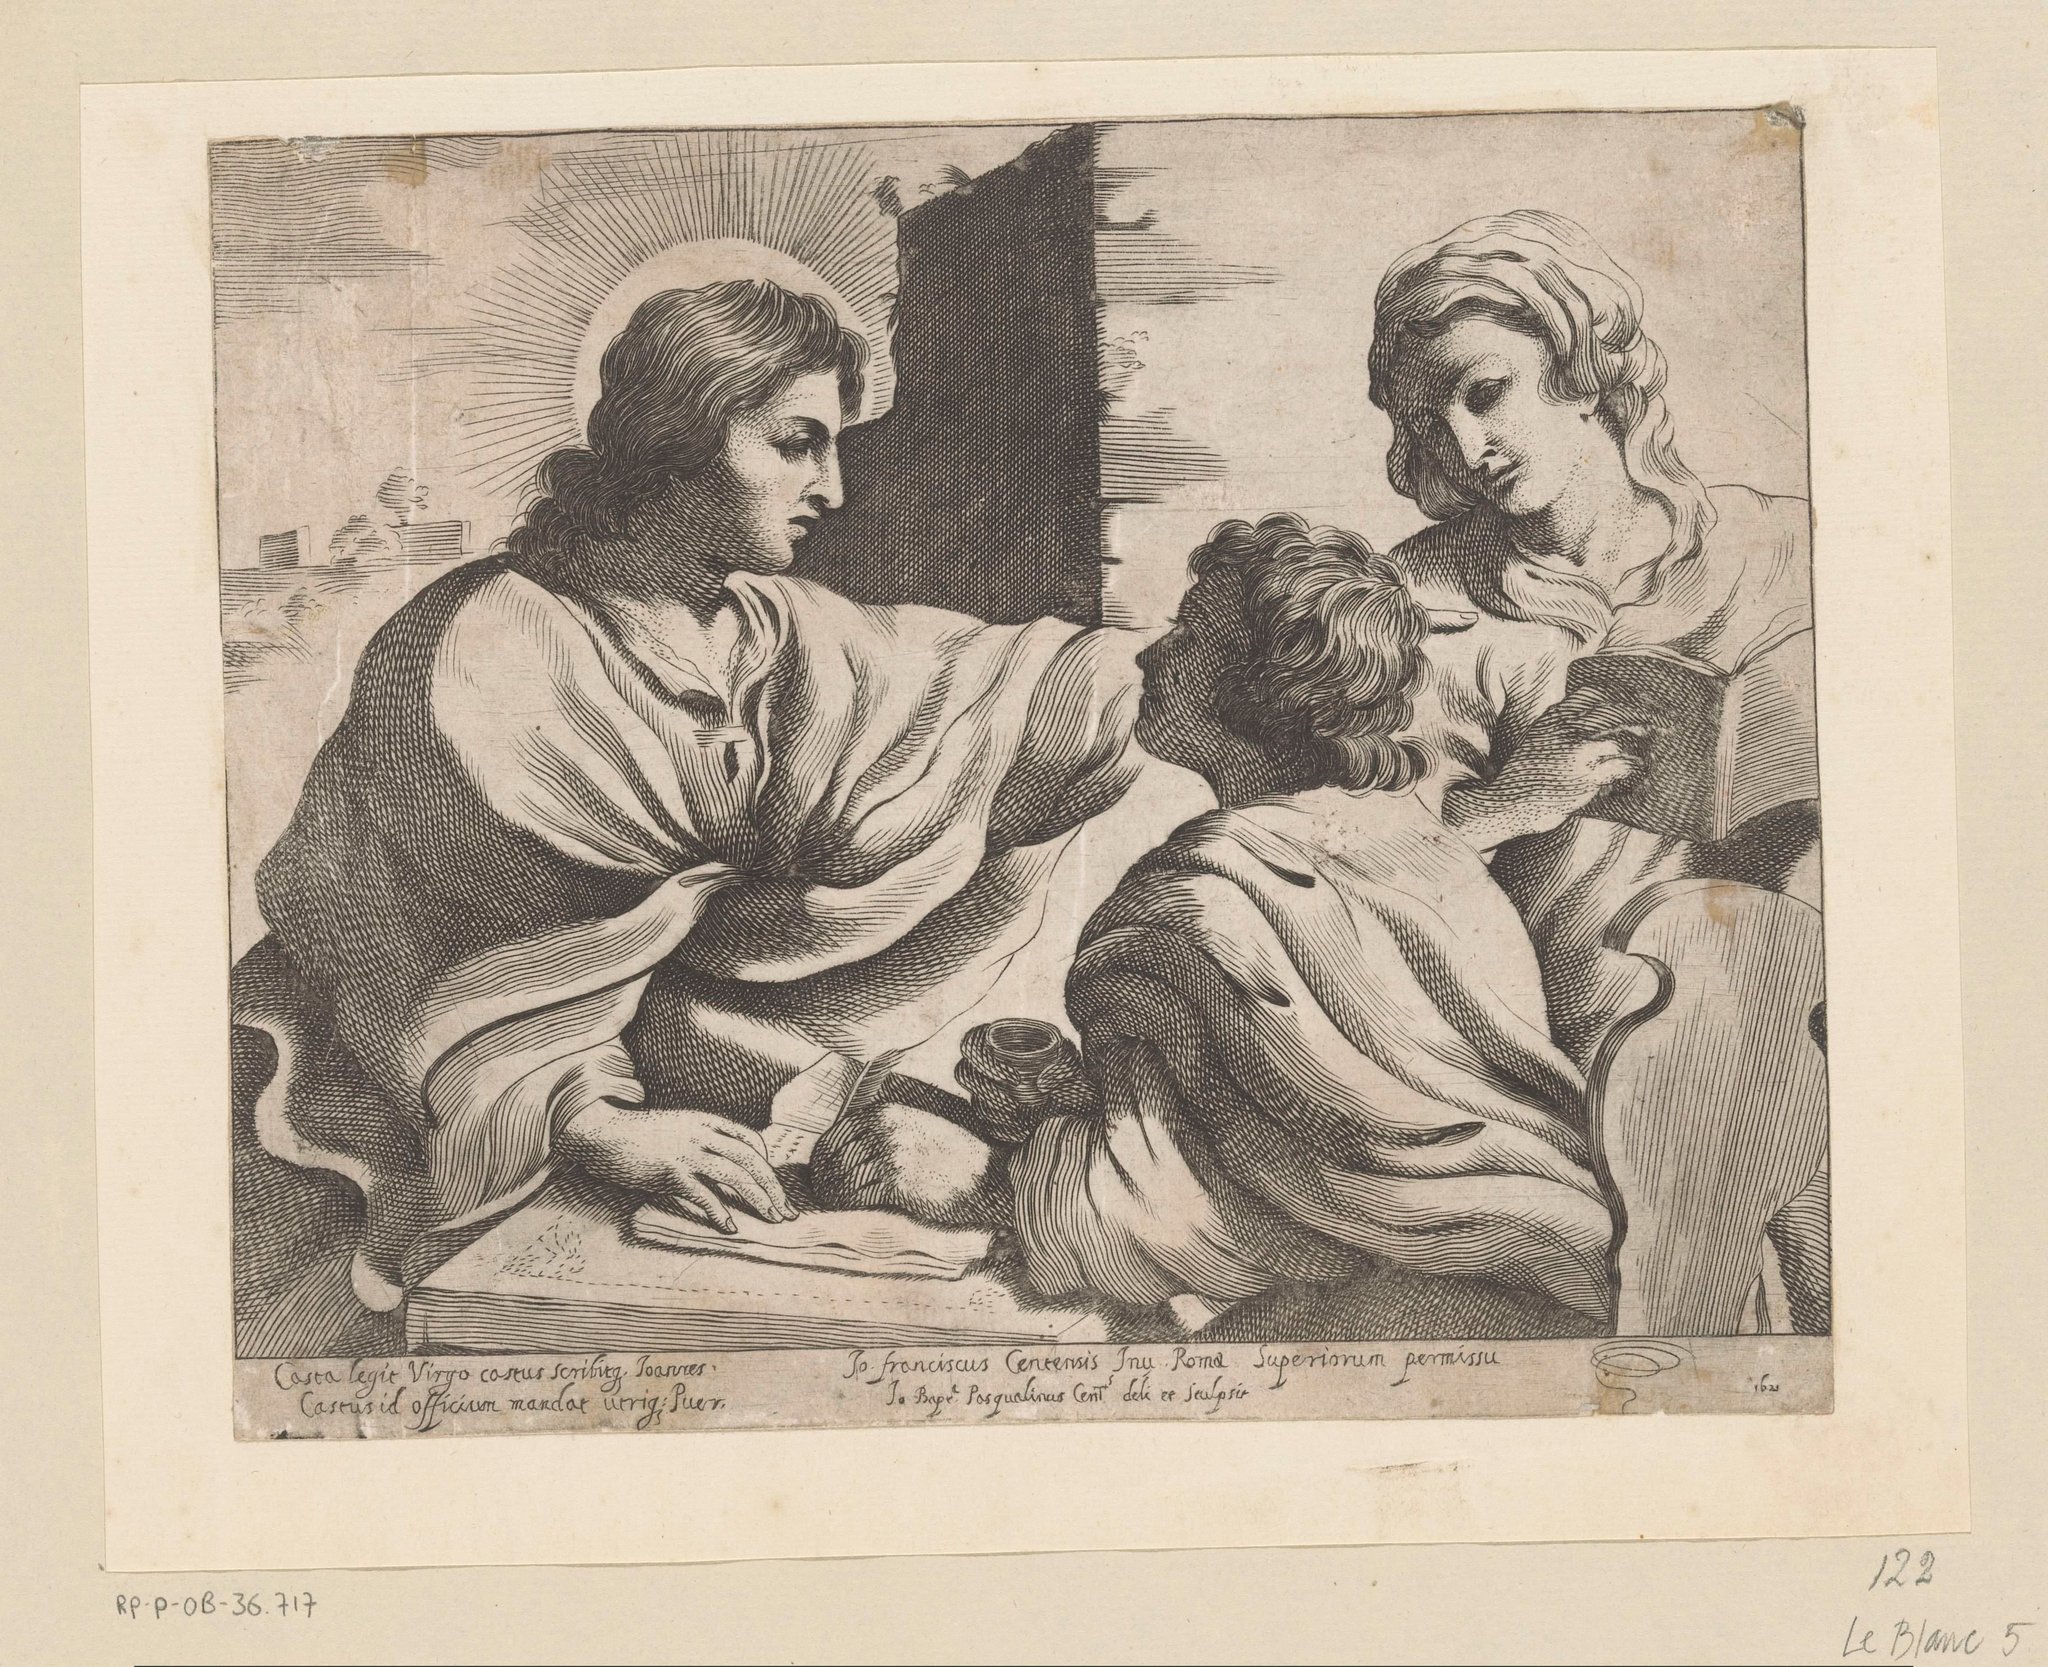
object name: print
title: Johannes de Doper, Christus en Maria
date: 1621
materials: paper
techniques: engraving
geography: italy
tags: john the baptist; possible attributes: book, reed cross, baptismal cup, honeycomb, lamb, staff, the virgin mary, ink, christ as child or youth (in general) ~ christian religion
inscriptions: collector's mark: Lugt 240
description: Christus als kind schrijft met pen en inkt in een boek. Links Johannes de Doper, rechts Maria met een boek in haar handen. In de ondermarge een tweeregelige tekst in het Latijn.